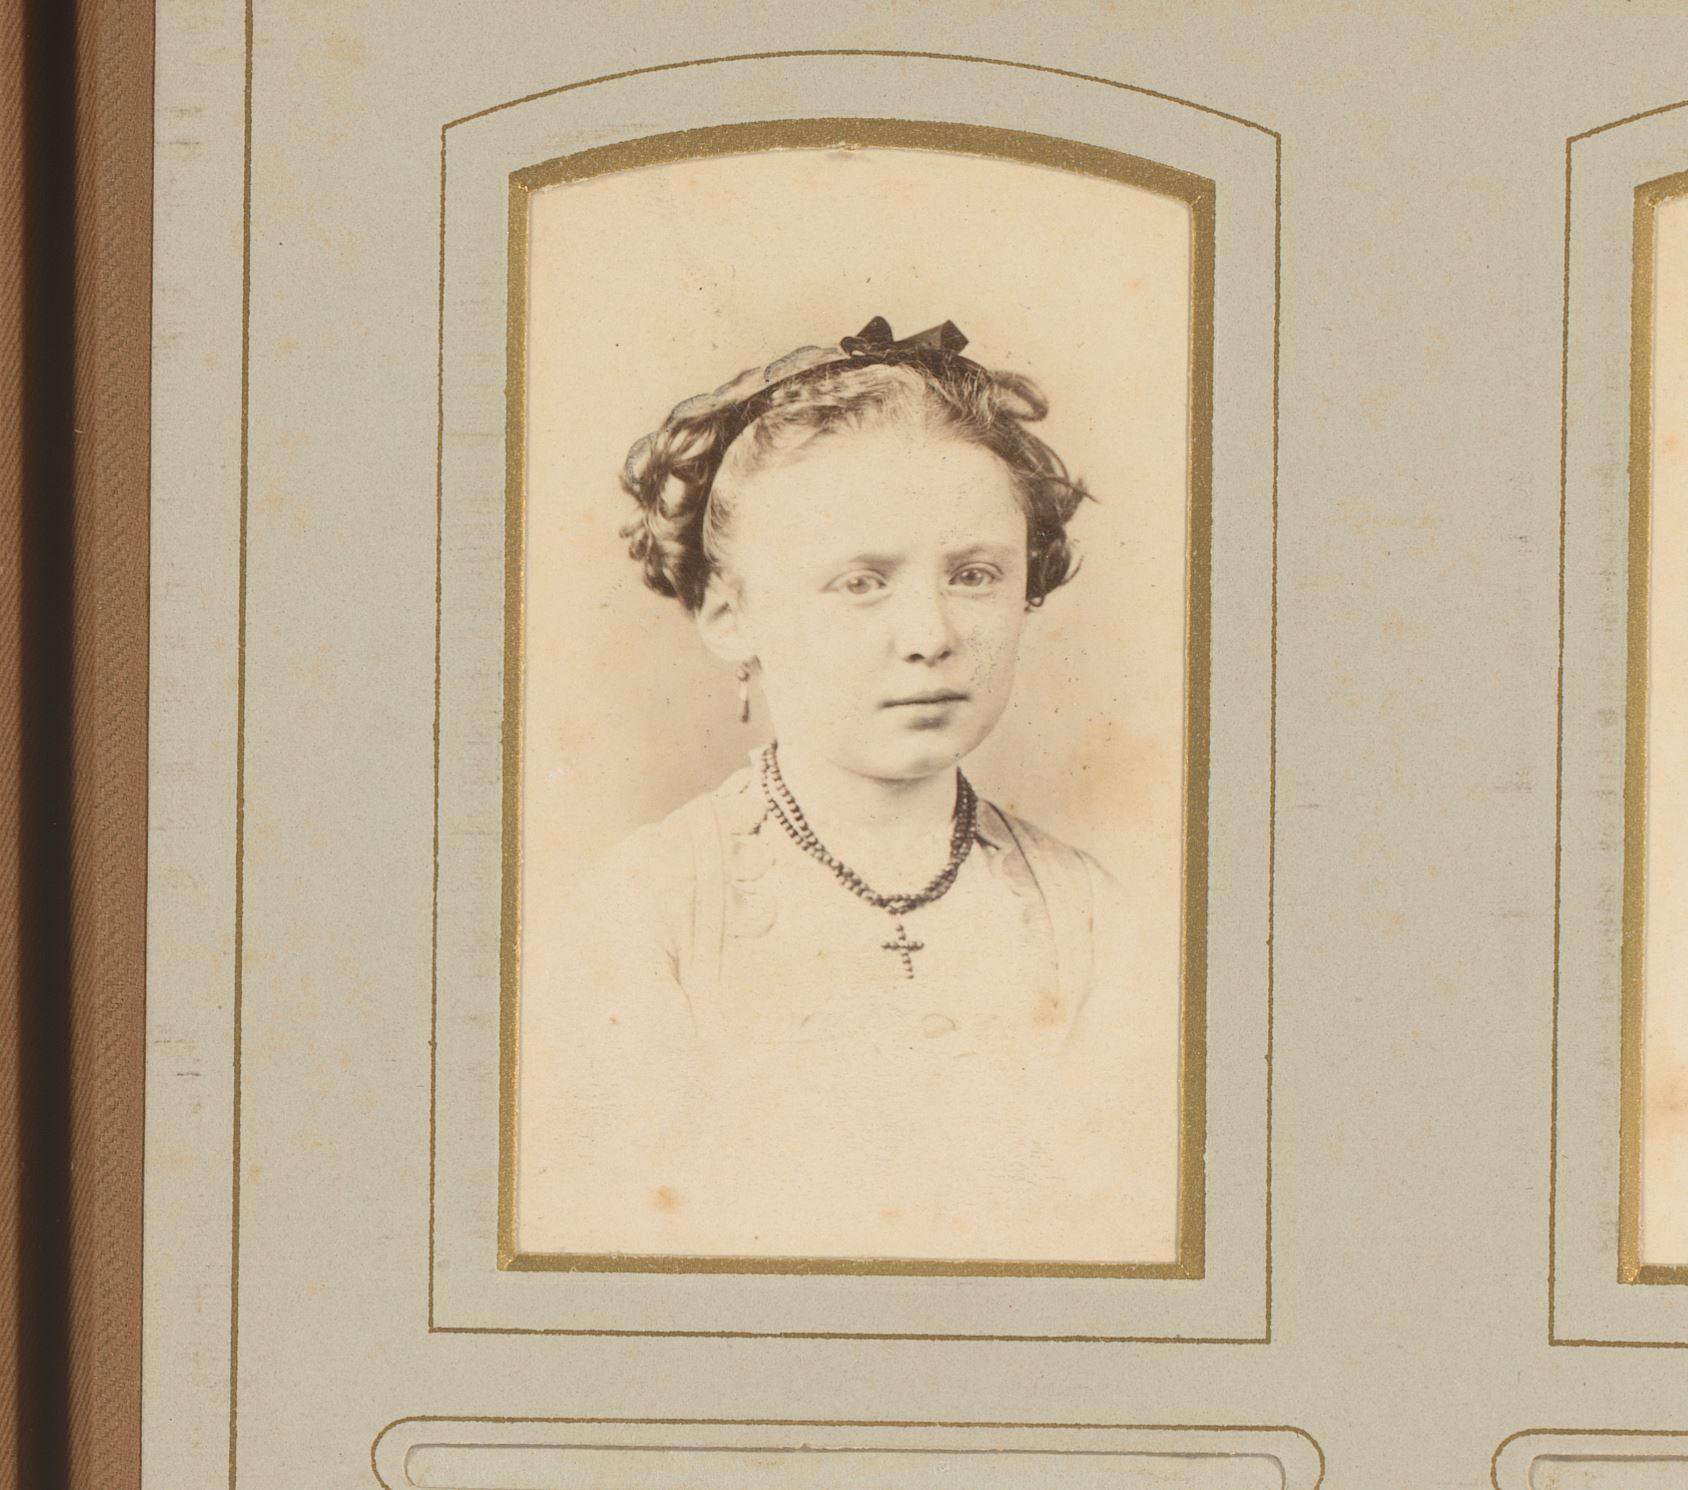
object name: photograph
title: Portret van een meisje met halsketting met kruis en strik in het haar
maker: palmer descamps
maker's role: goldsmith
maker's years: 1840-1884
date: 1865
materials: cardboard, photographic support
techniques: albumen print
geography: kortrijk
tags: historical persons - bb - woman, the cross ~ symbols of christ, girl (child between toddler and youth), hairdress, necklace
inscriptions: inscription: ‘COURTRAI/ RUE DE LA LYS, 13./ PHOTOGRAPHIE/ Descamps/ PALMER/ ORFÈVRERIE’